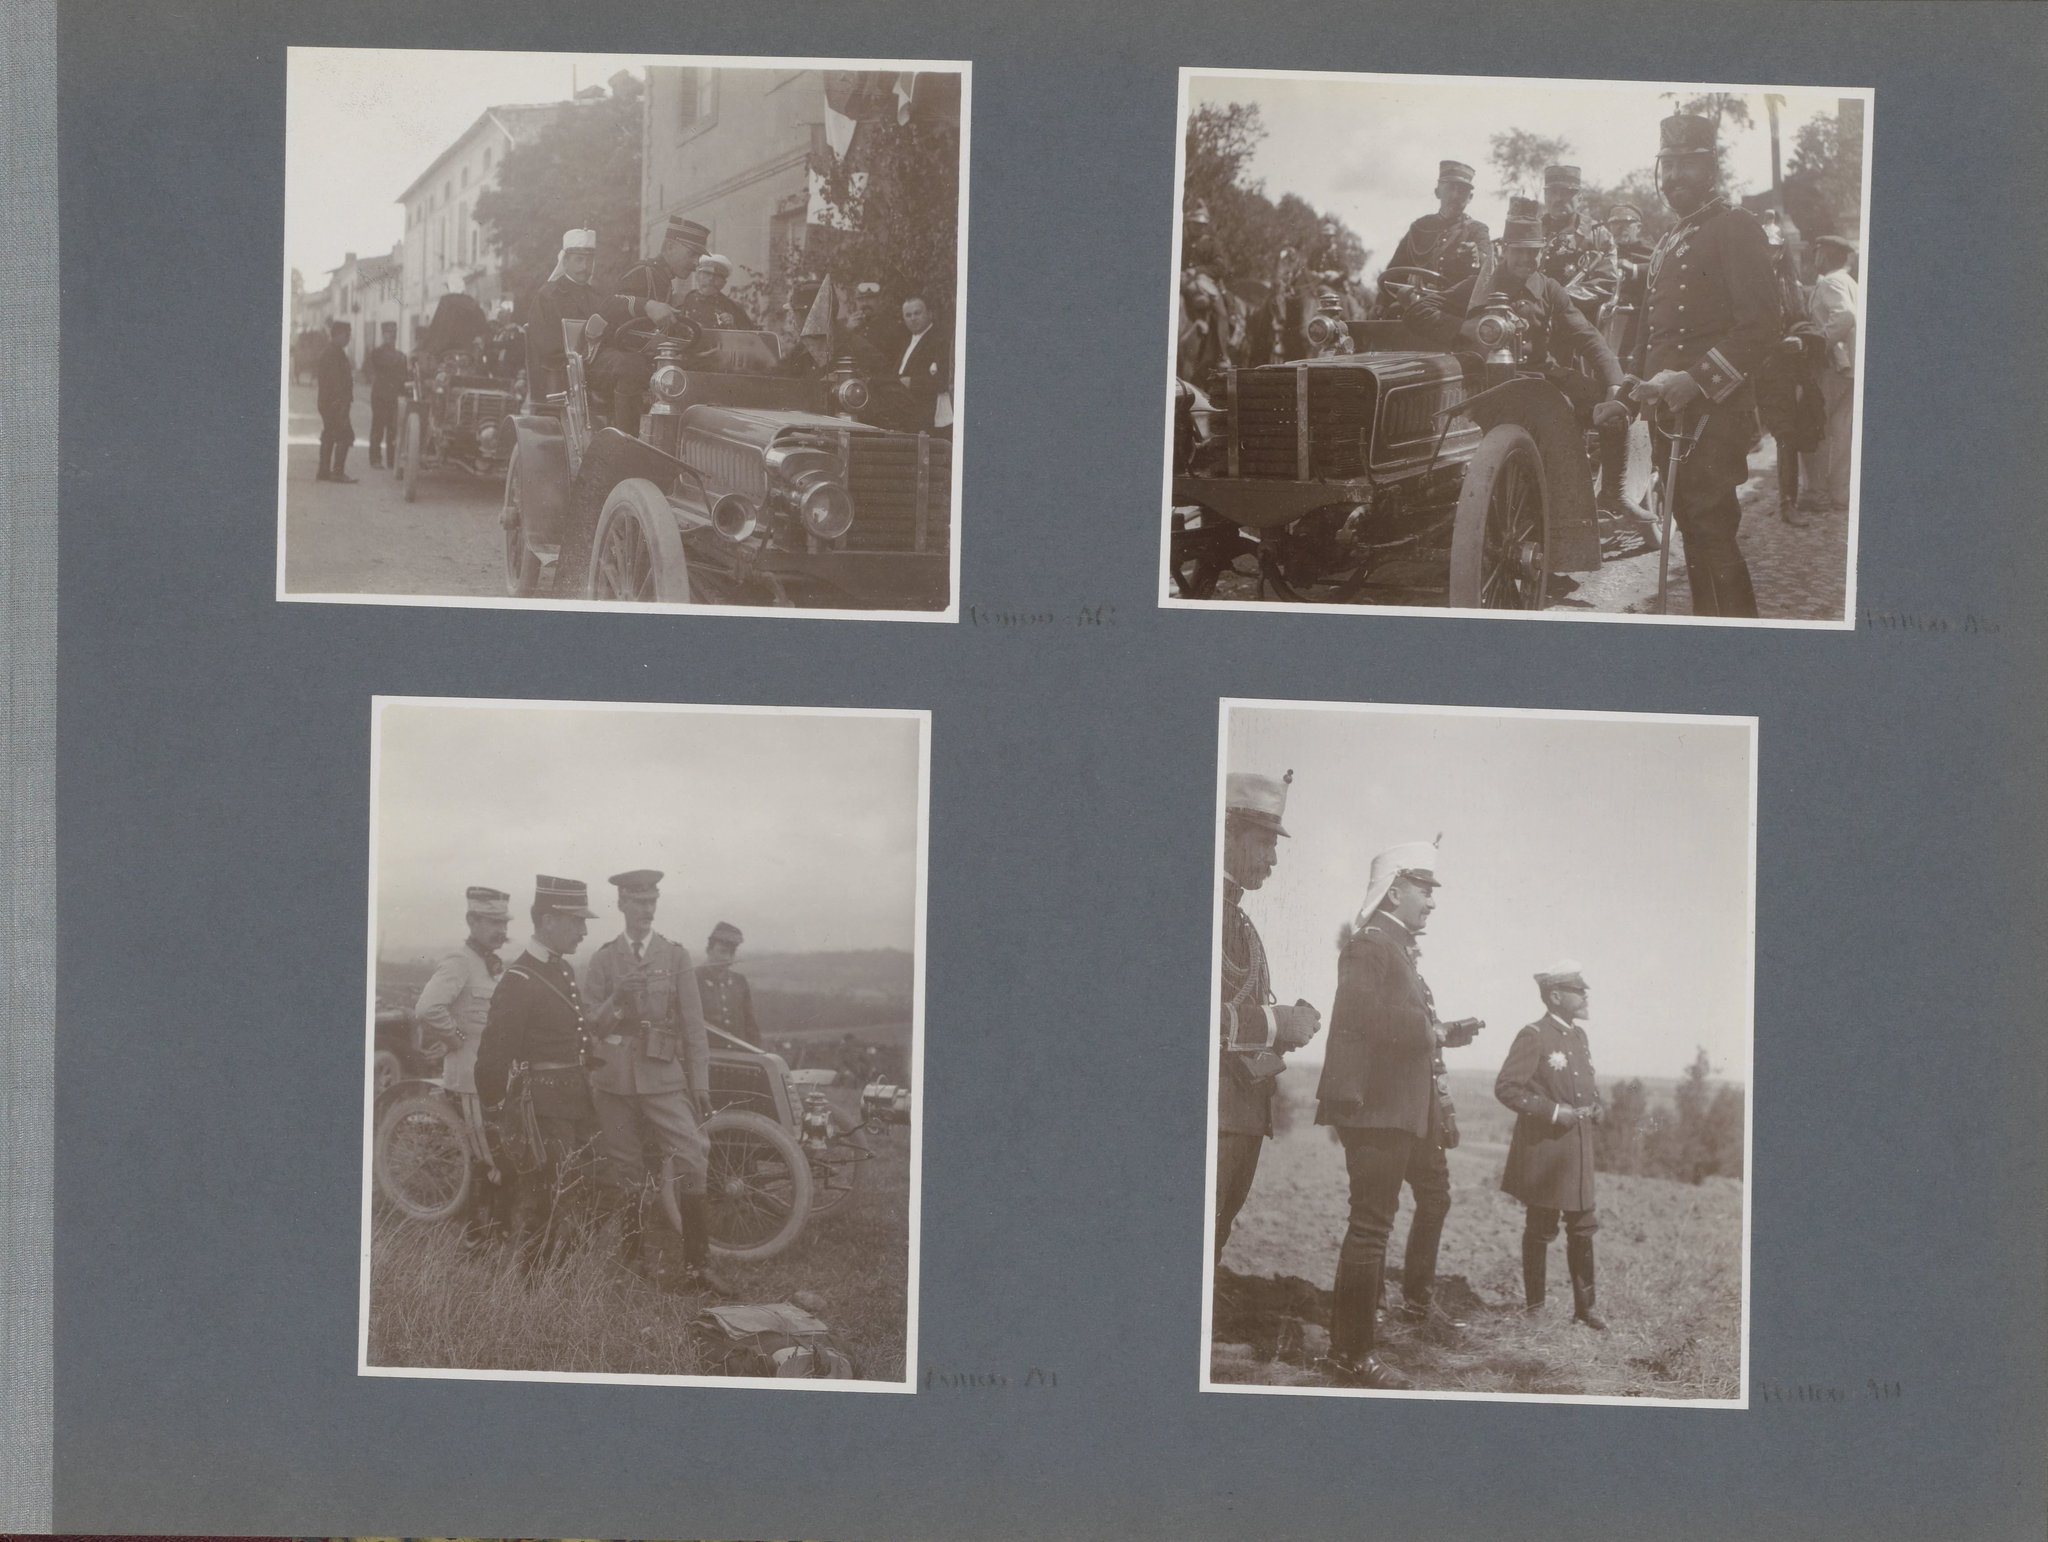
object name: album leaf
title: Auto's met militairen in een Franse straat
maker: Anonymous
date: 1902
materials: paper, photographic support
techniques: daylight paper print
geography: france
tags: land forces, automobile, france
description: Onderdeel van Fotoalbum van een legeroefening in Zuidwest-Frankrijk in 1902.